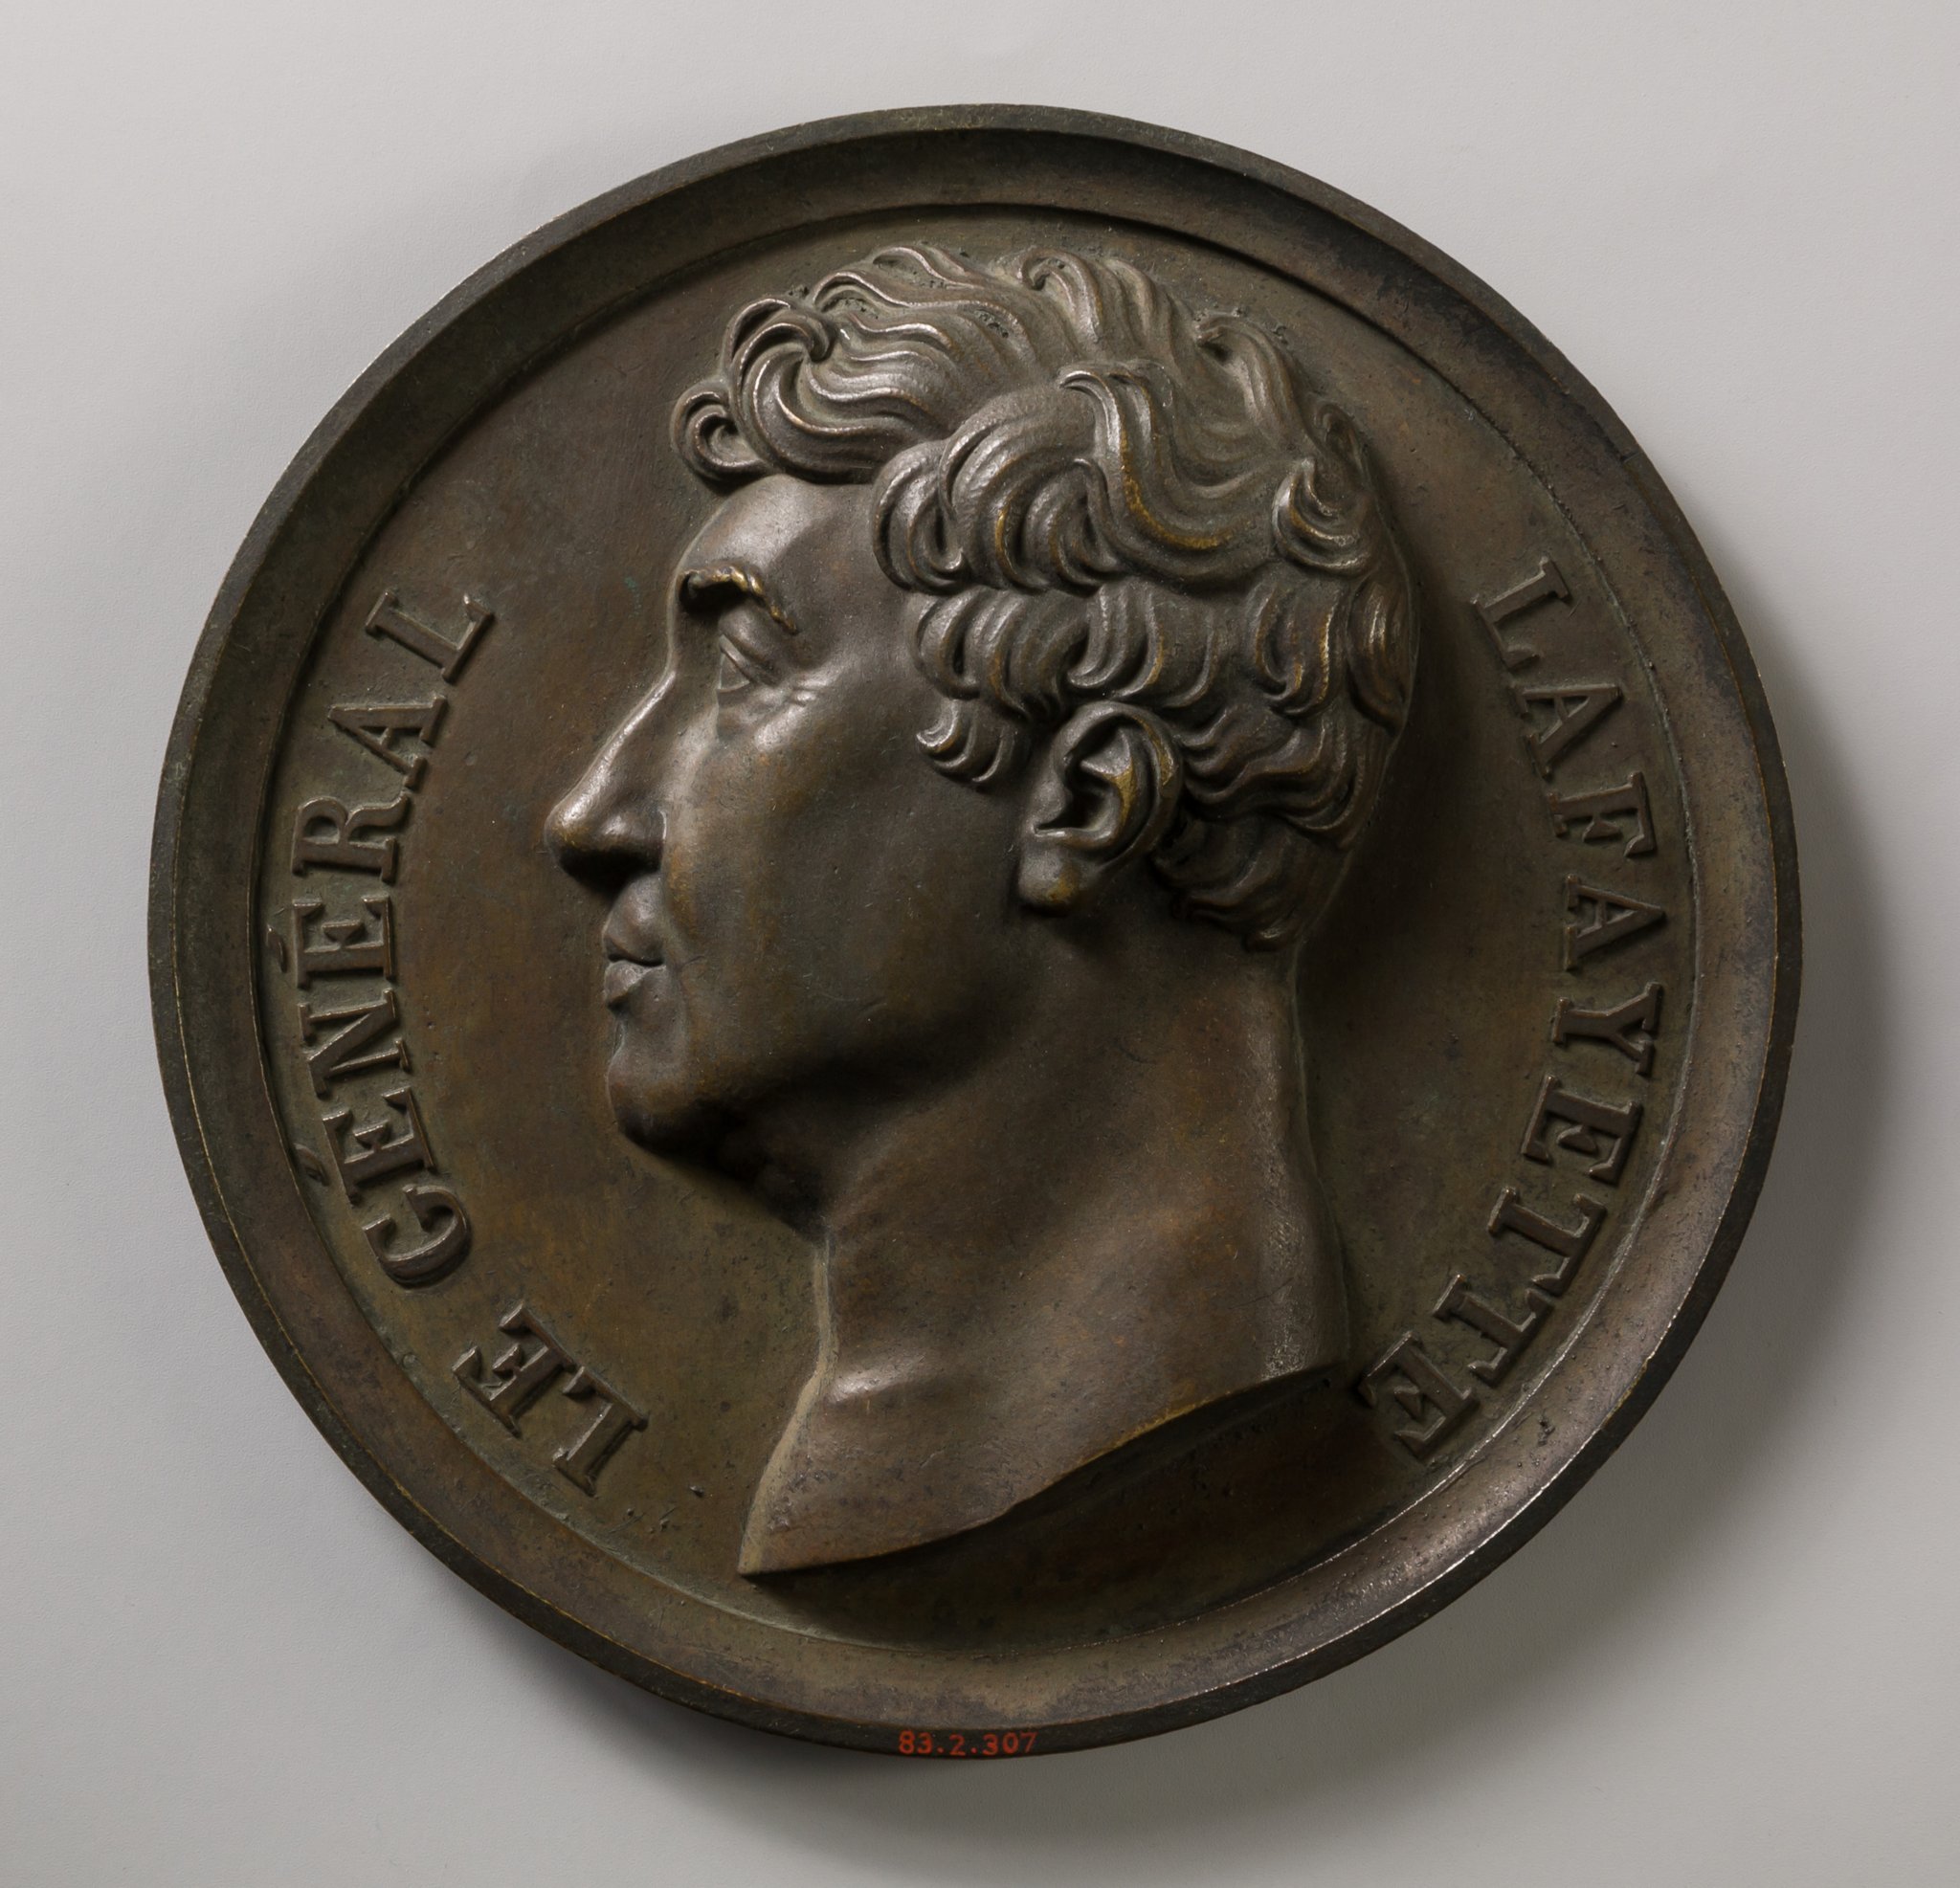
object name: medallion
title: Medallion of the Marquis de Lafayette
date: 1800-1883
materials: bronze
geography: france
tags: men,profiles,marquis de lafayette